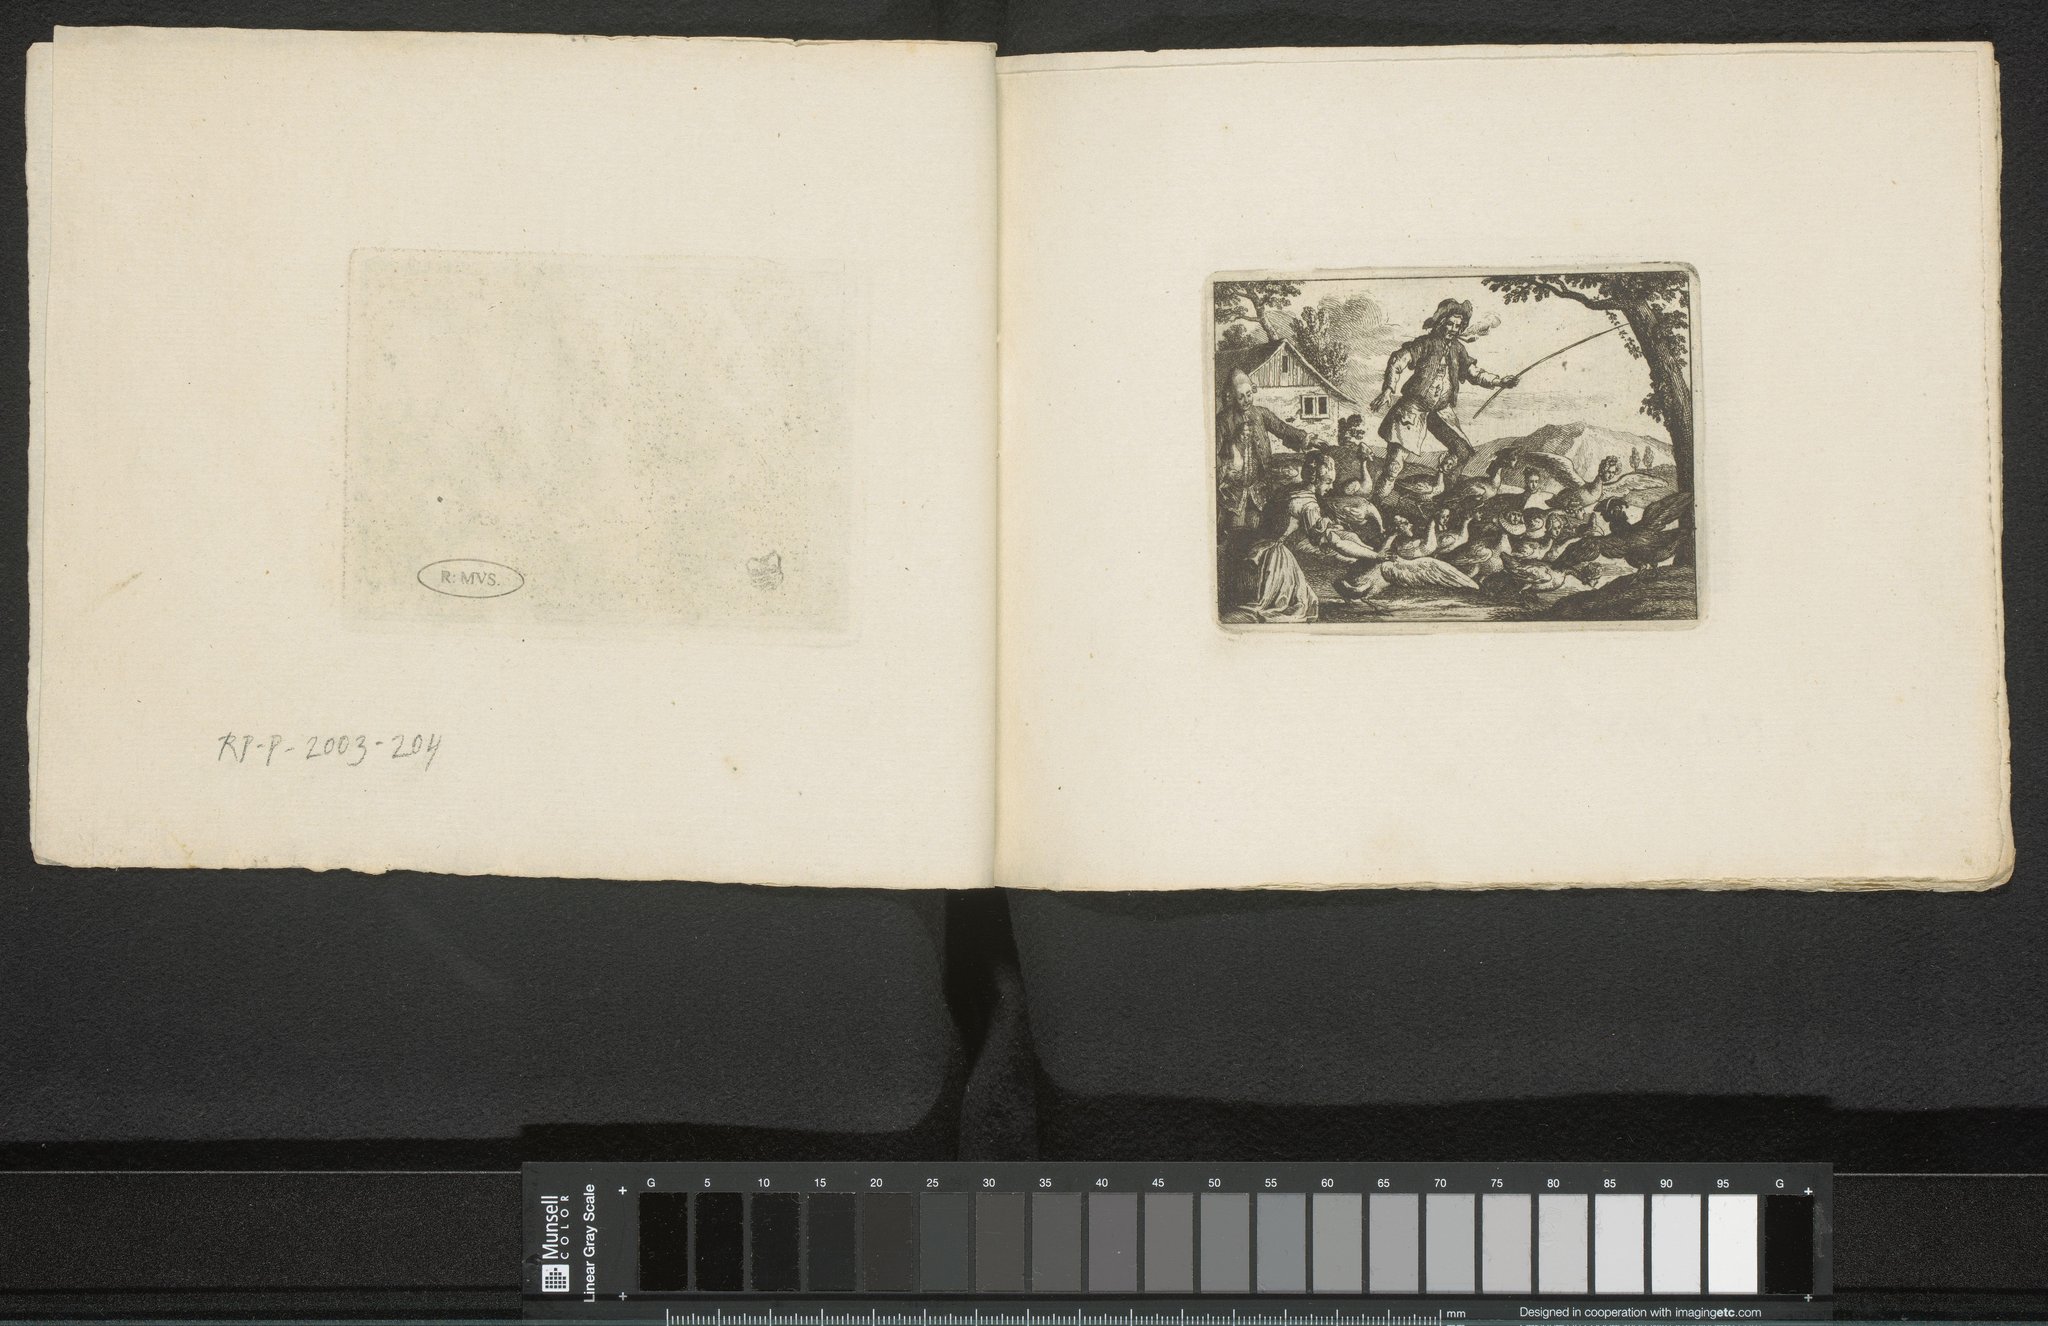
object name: cartoon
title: Ganzenhoeder met kudde ganzen met vrouwenhoofden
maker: johann rudolph schellenberg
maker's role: print maker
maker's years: 1740-1806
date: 1772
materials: paper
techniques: etching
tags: animals with human head, political caricatures and satires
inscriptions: collector's mark: Lugt 2228